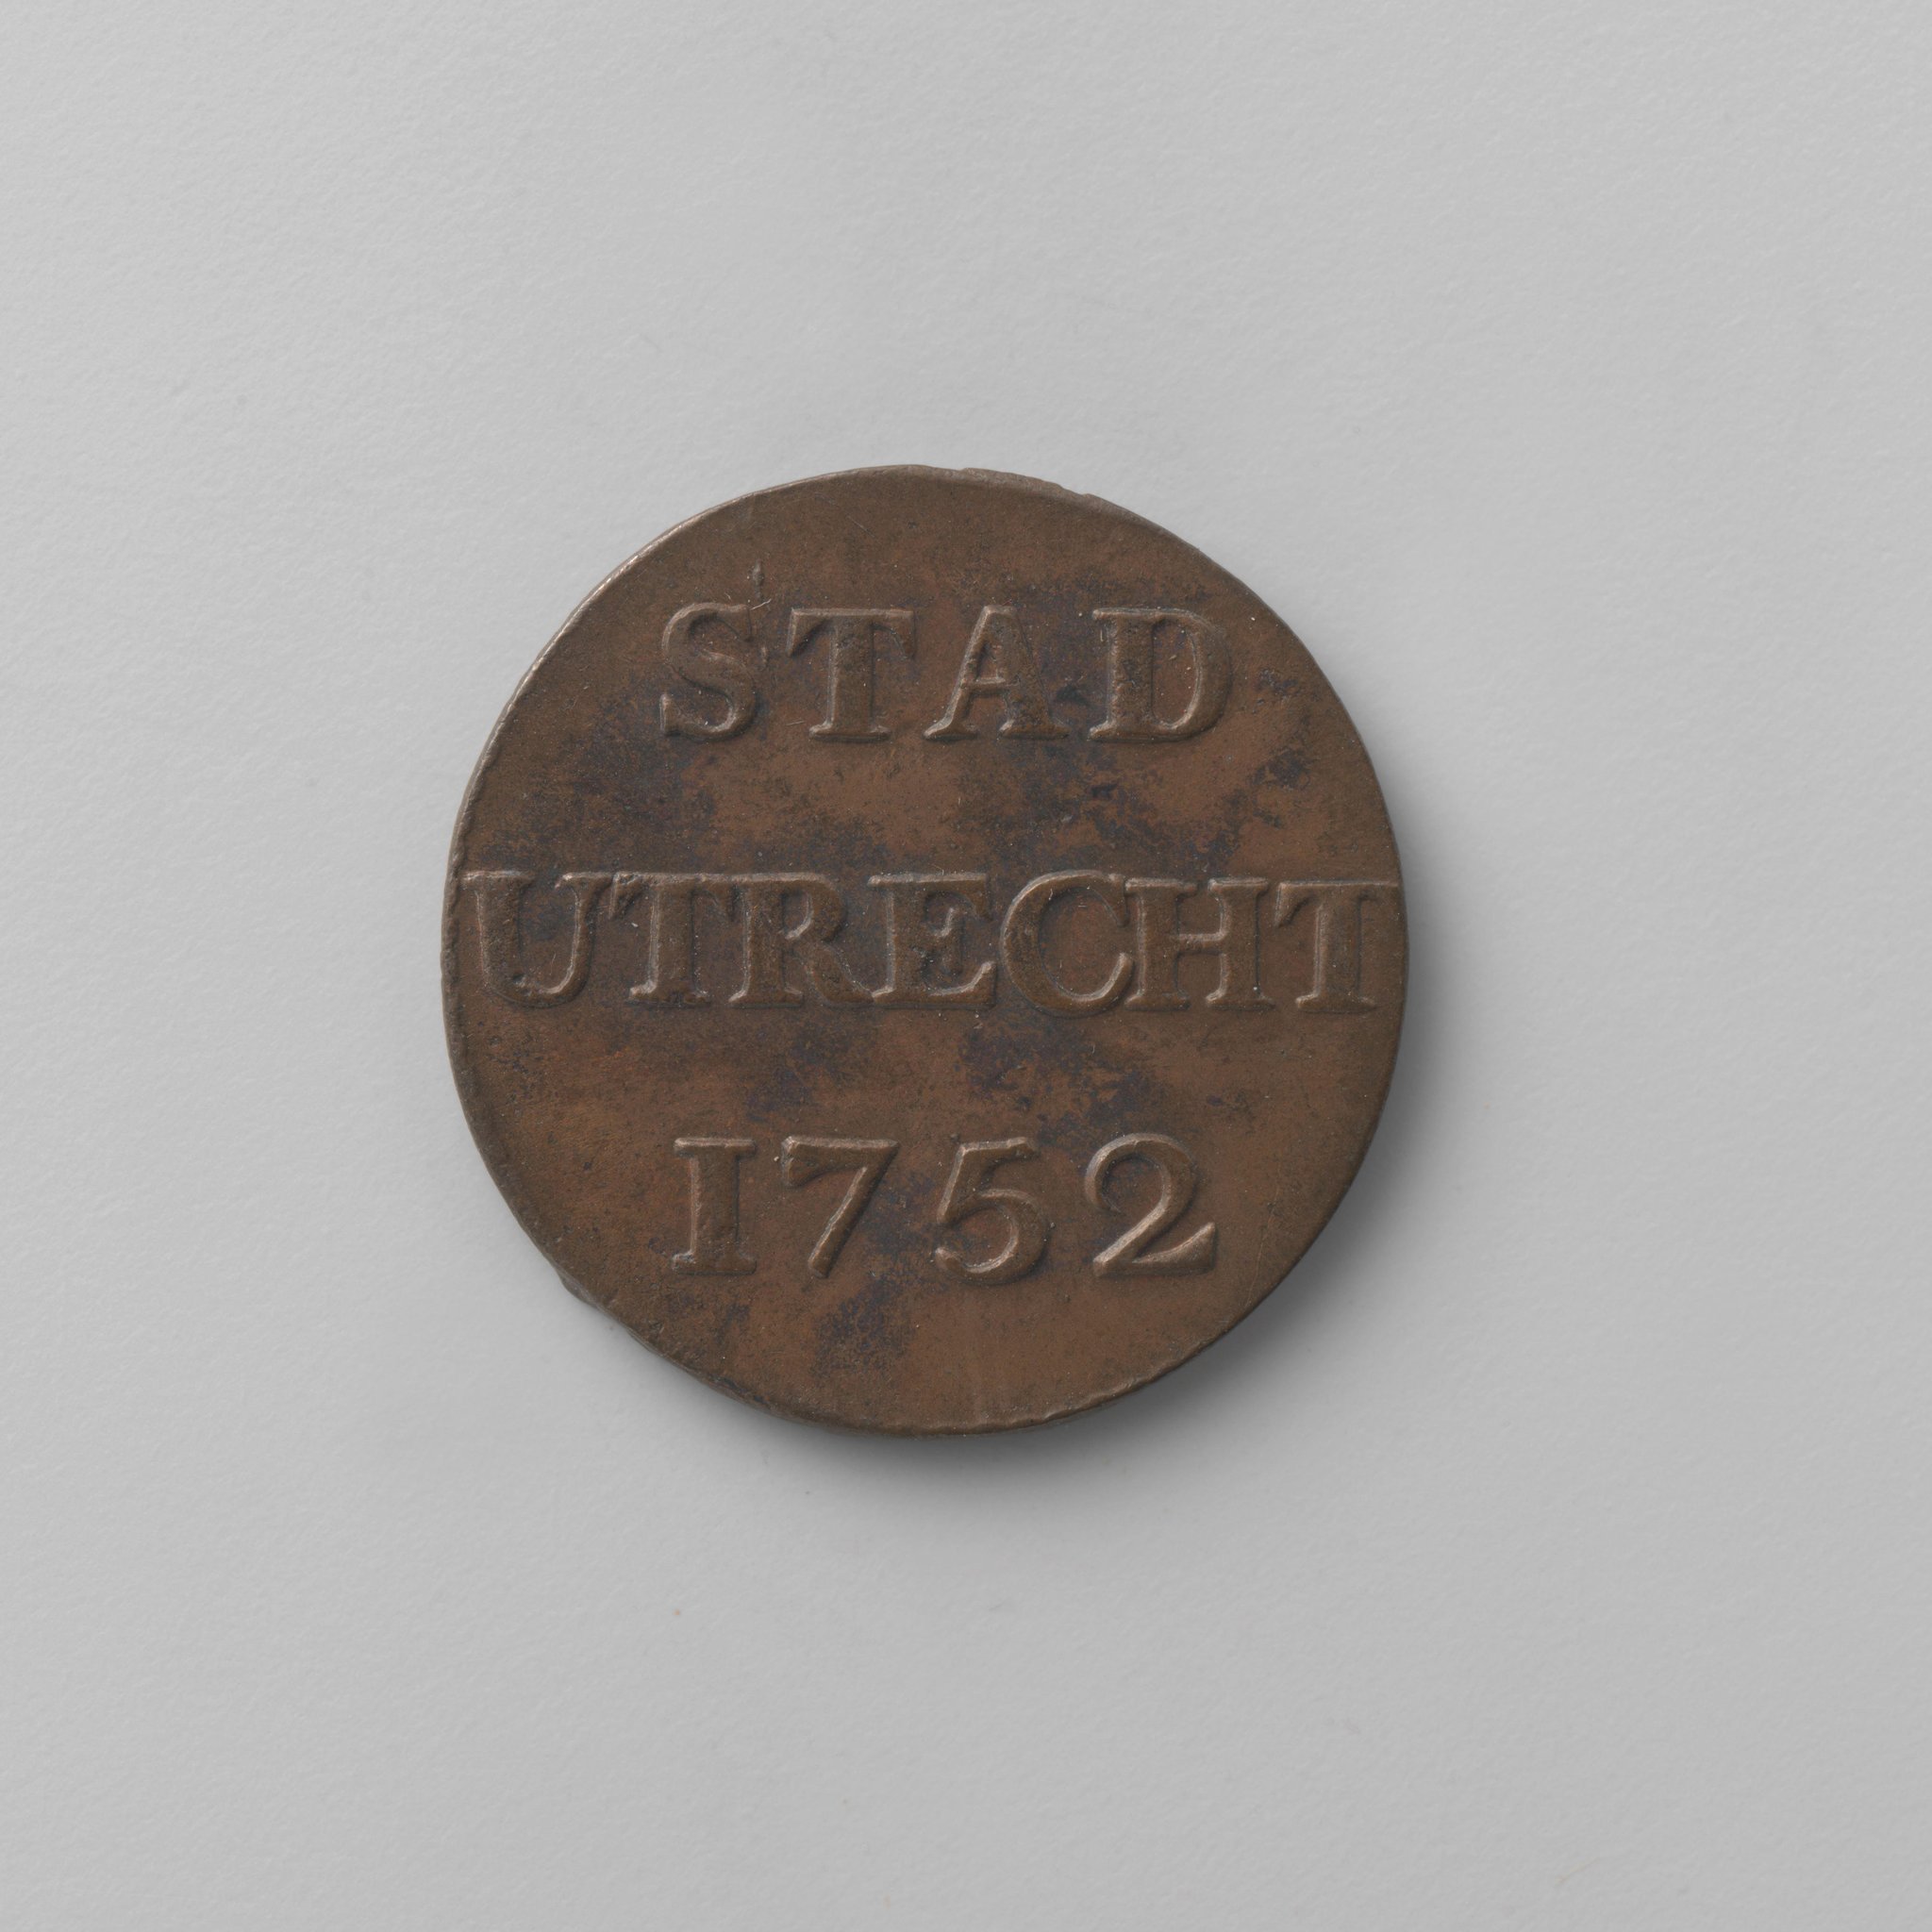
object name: coin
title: Duit van de stad Utrecht, 1752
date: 1752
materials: copper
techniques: striking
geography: utrecht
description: Koperen munt. Voorzijde: gekroond stedelijk wapenschild, gehouden door twee leeuwen met in afsnede dunne lijn, waaronder een versierde accolade met een grote schelp. Keerzijde: opschrift in twee regels, waaronder jaartal. Jaartal met Romeinse I.